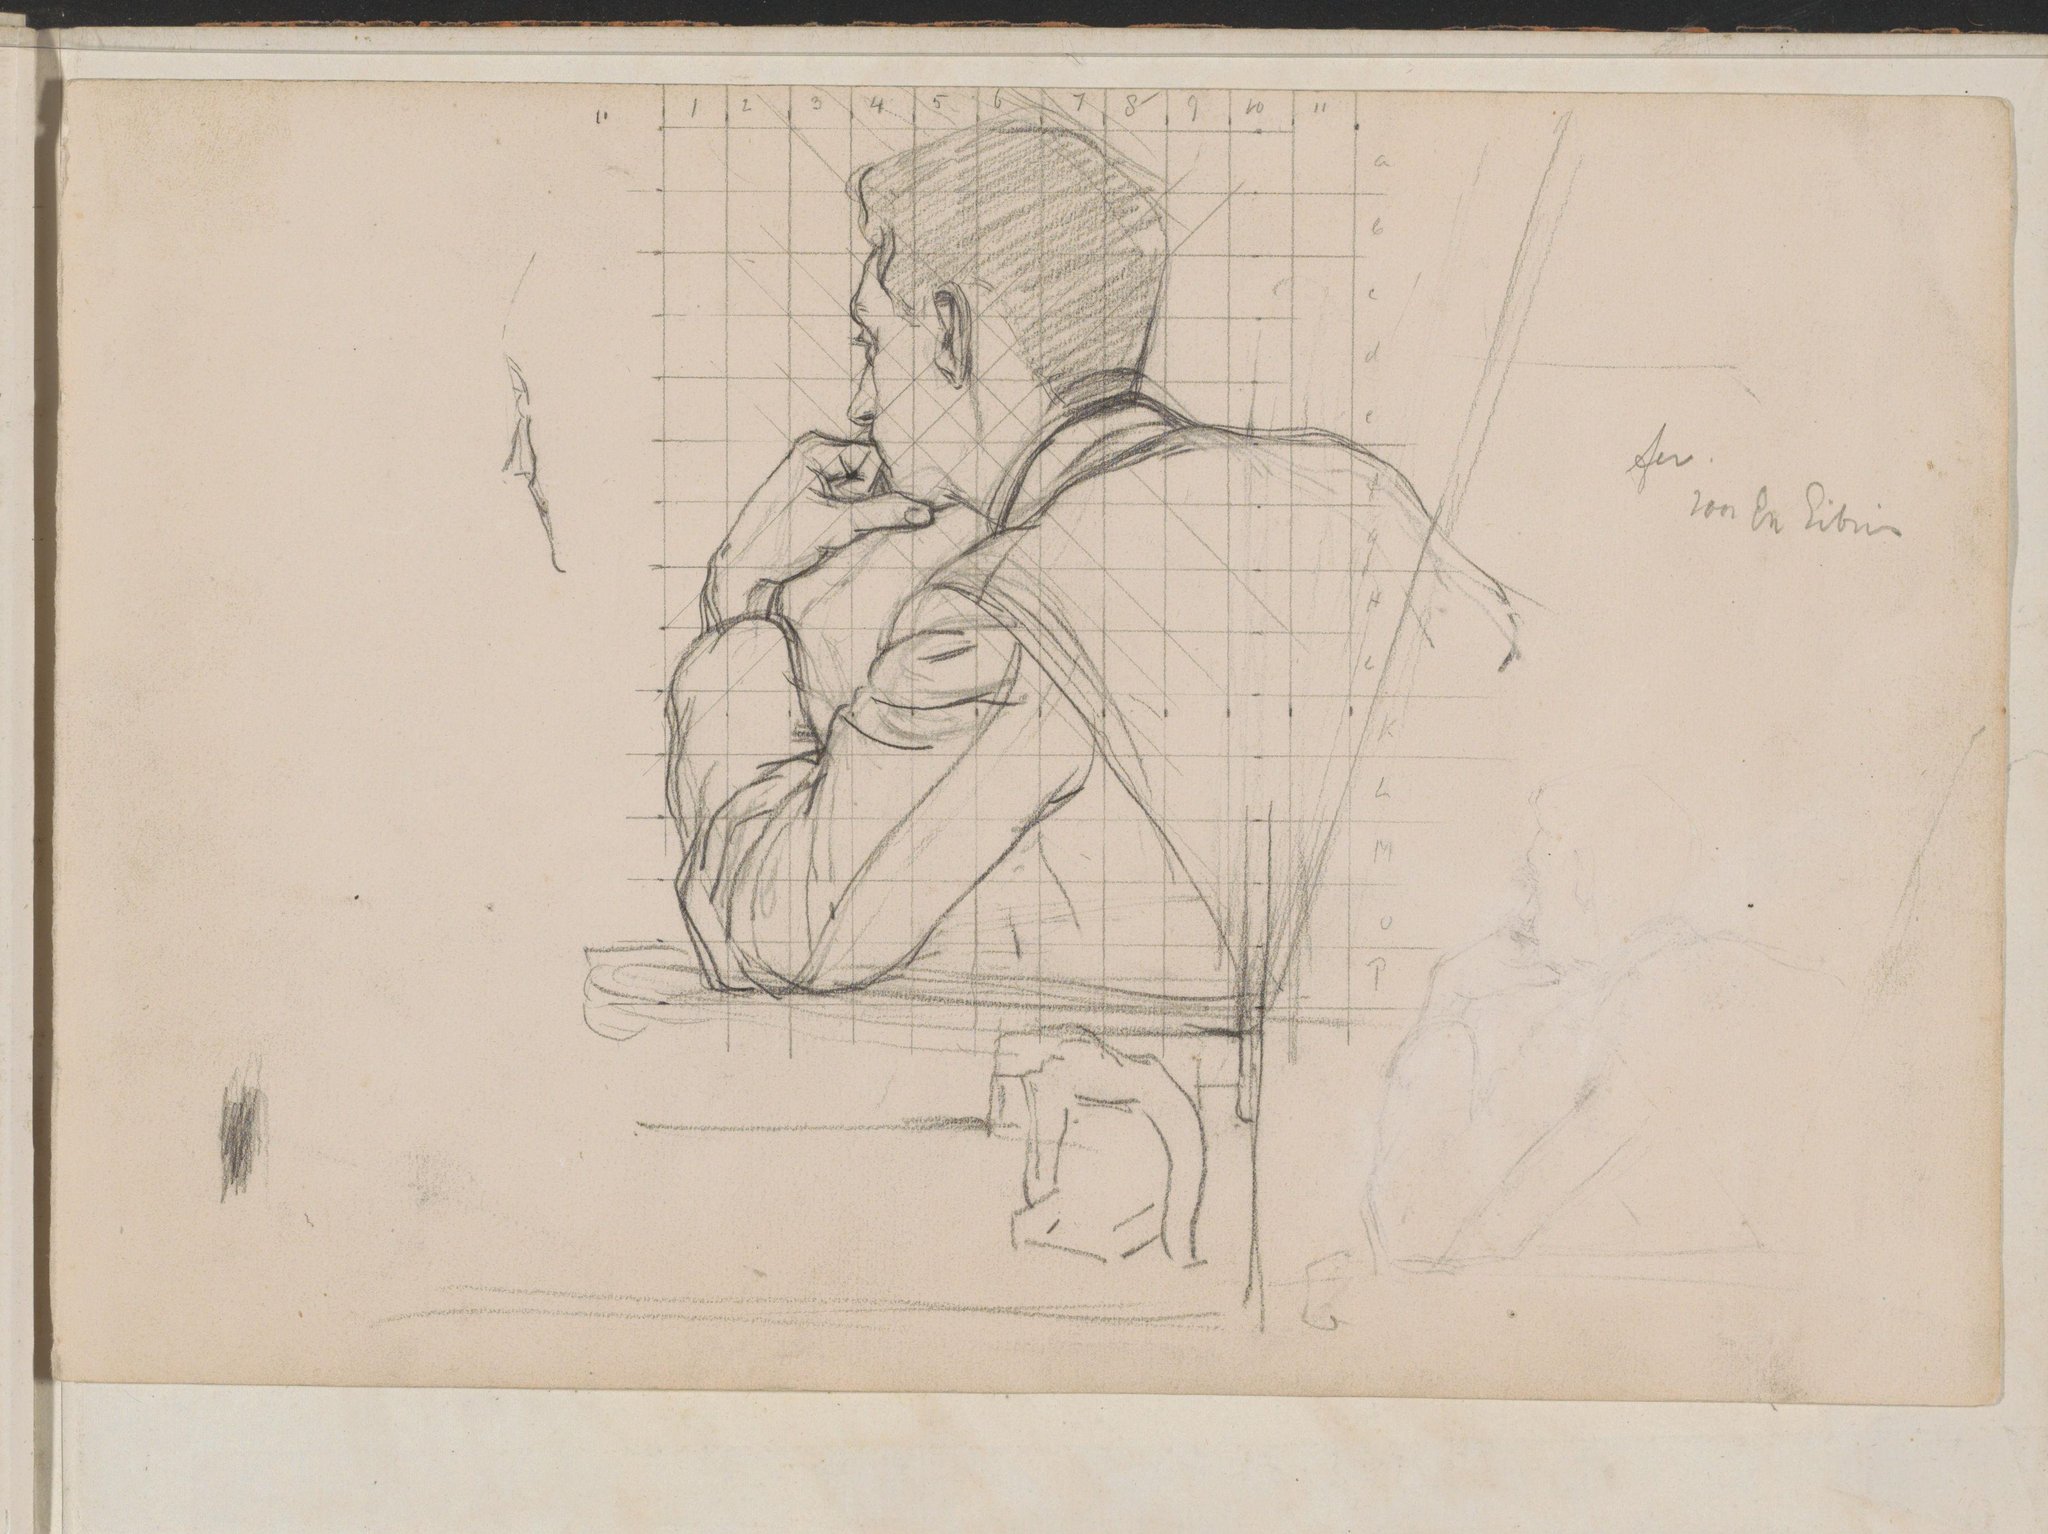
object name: sketchbook leaf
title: Jongeman die met zijn elleboog op een tafel leunt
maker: ferdinand oldewelt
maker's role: draughtsman, print maker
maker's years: 1857-1935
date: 1904-1912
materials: chalk, paper, pencil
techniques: drawing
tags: youth, adolescent, hand(s) bent towards the head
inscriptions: annotation: ‘[...]er/ voor Ex Libris’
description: De jongeman ondersteunt zijn hoofd met zijn linkerhand. Tevens een studie van een gezicht in profiel naar links. Recto van een los blad tussen blad 27 en het achterste schutblad uit een schetsboek met 27 bladen.